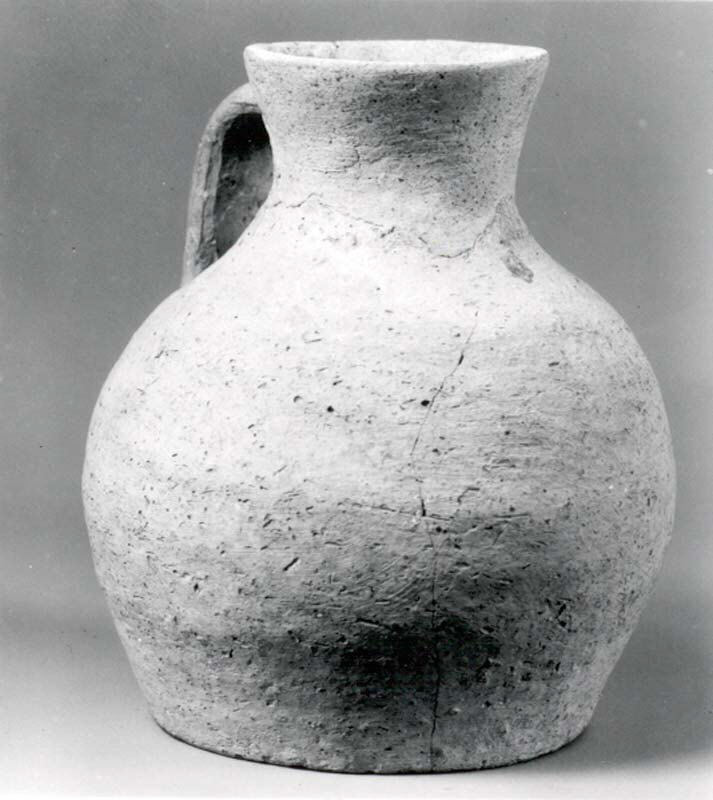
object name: jug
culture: sasanian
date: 201-700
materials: ceramic, glaze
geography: iran